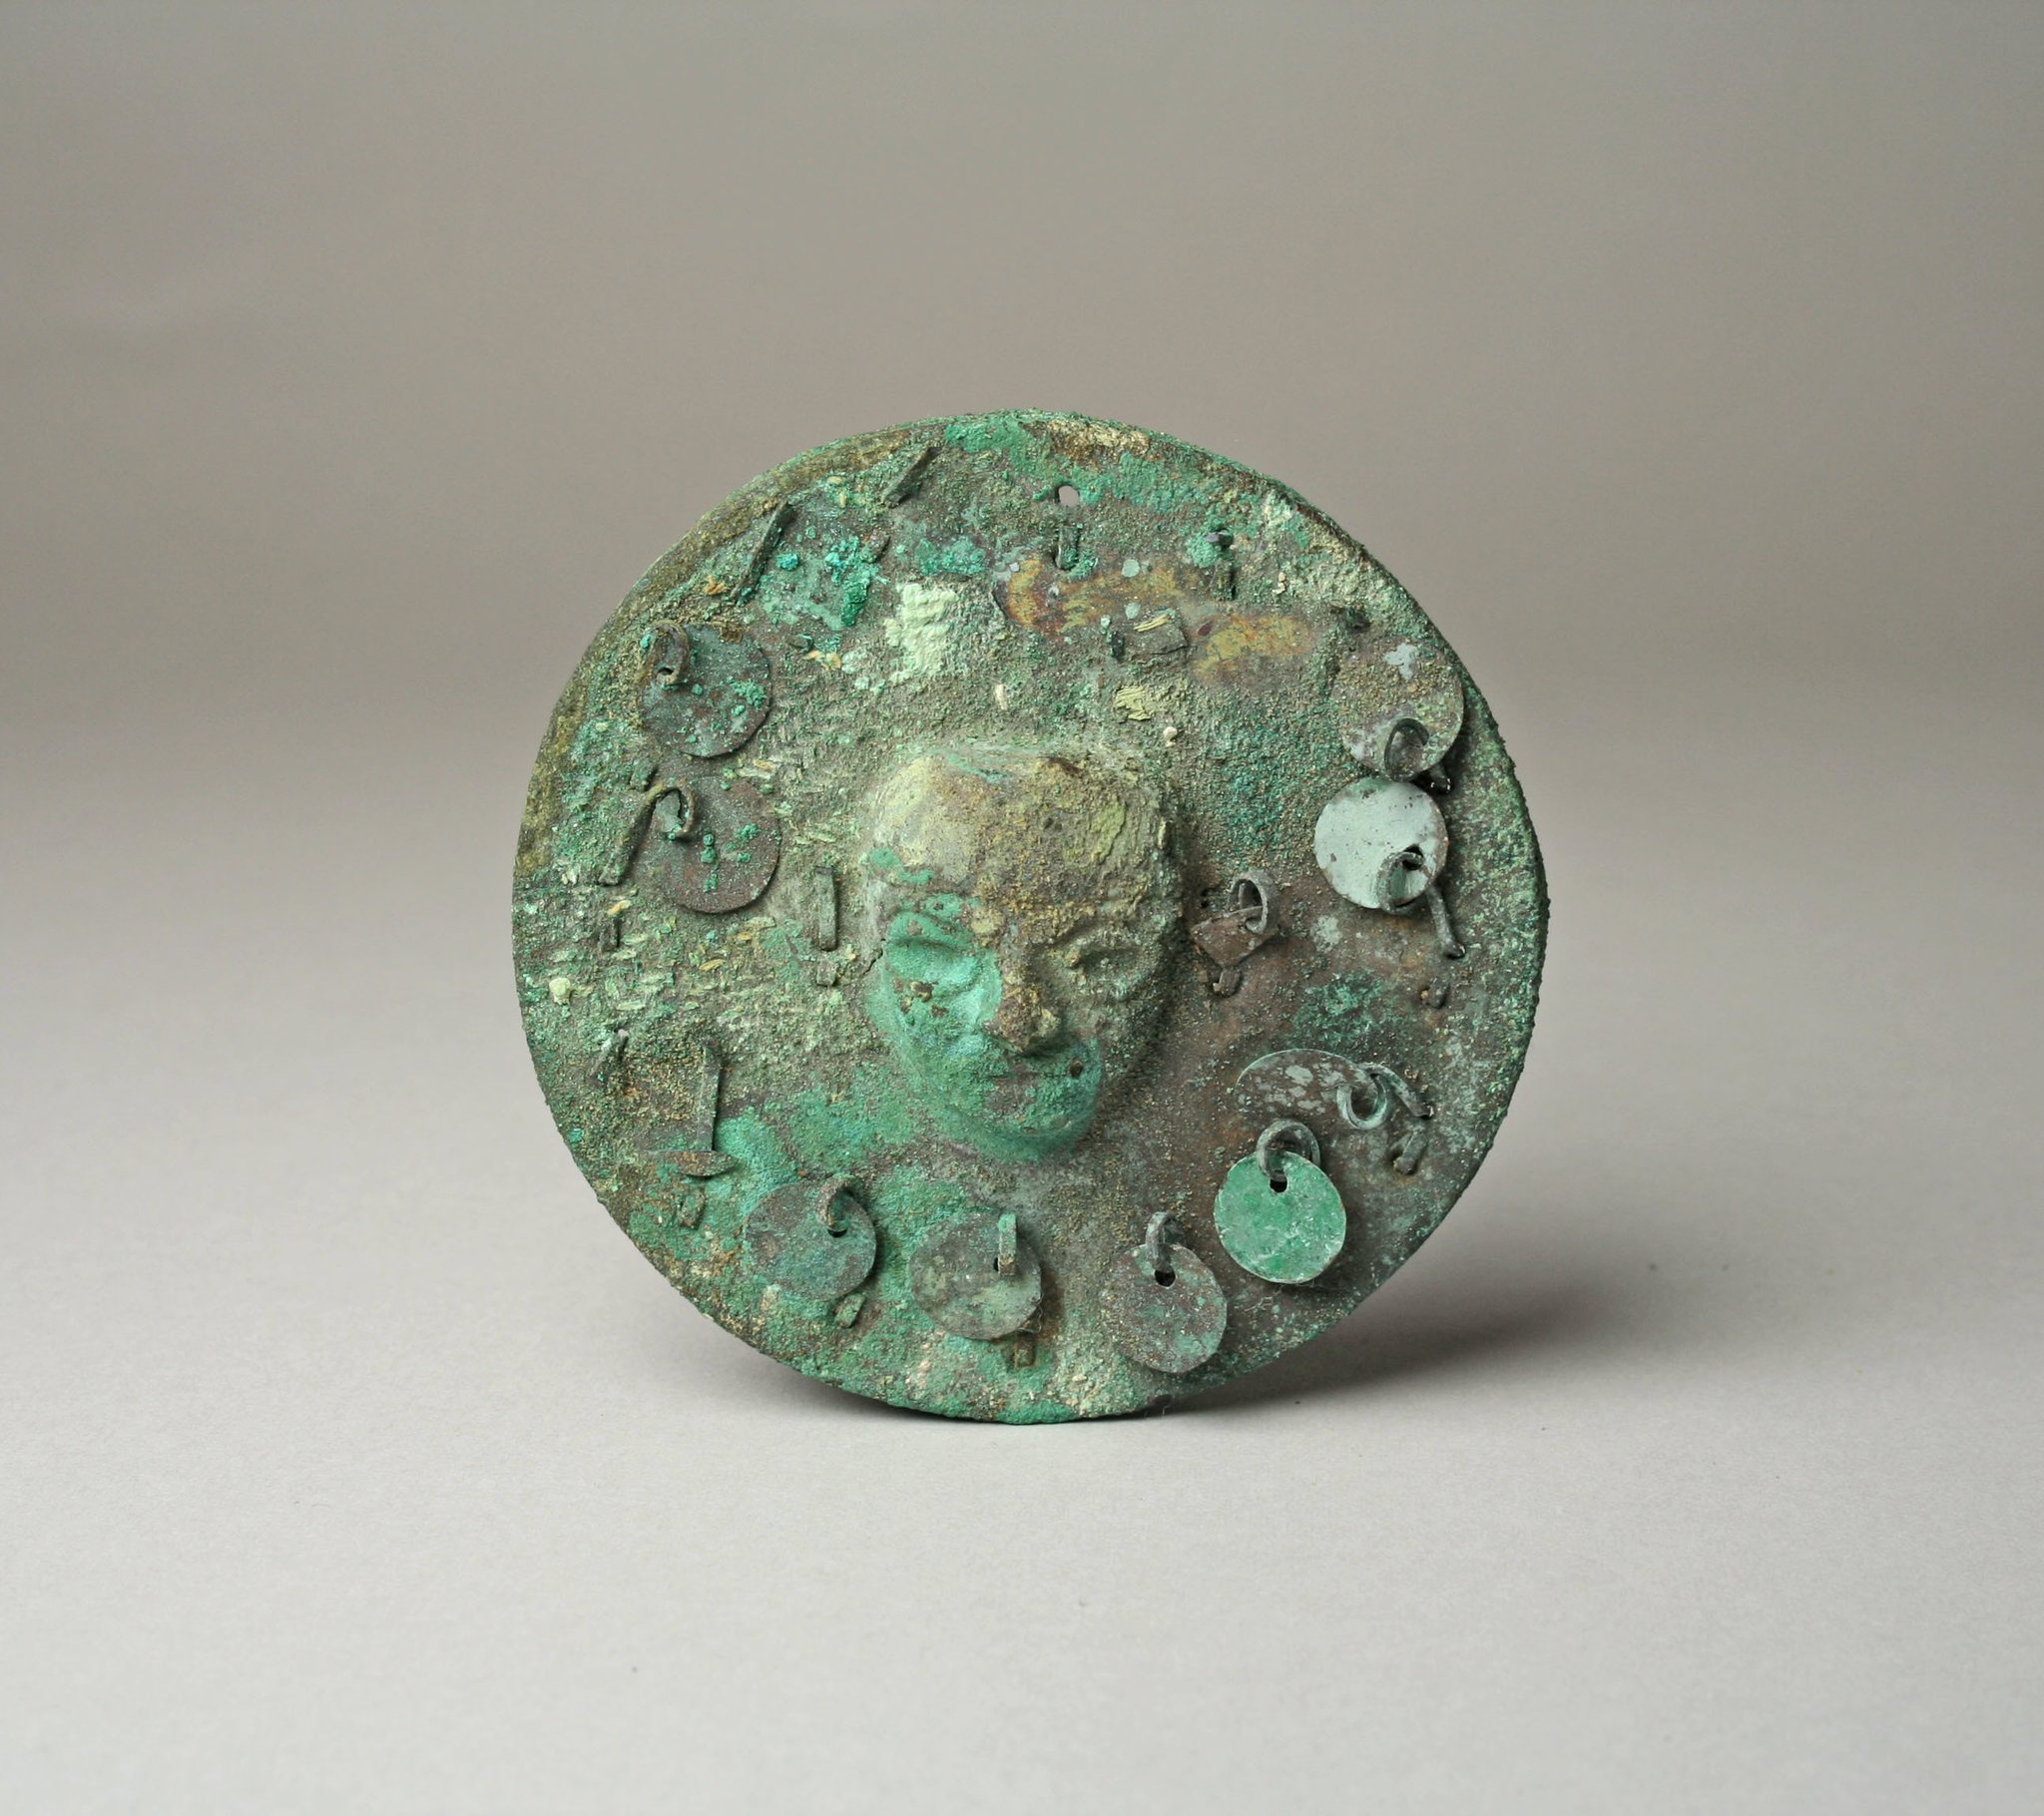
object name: earflare frontal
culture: moche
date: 501-700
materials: gilt copper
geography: peru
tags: faces